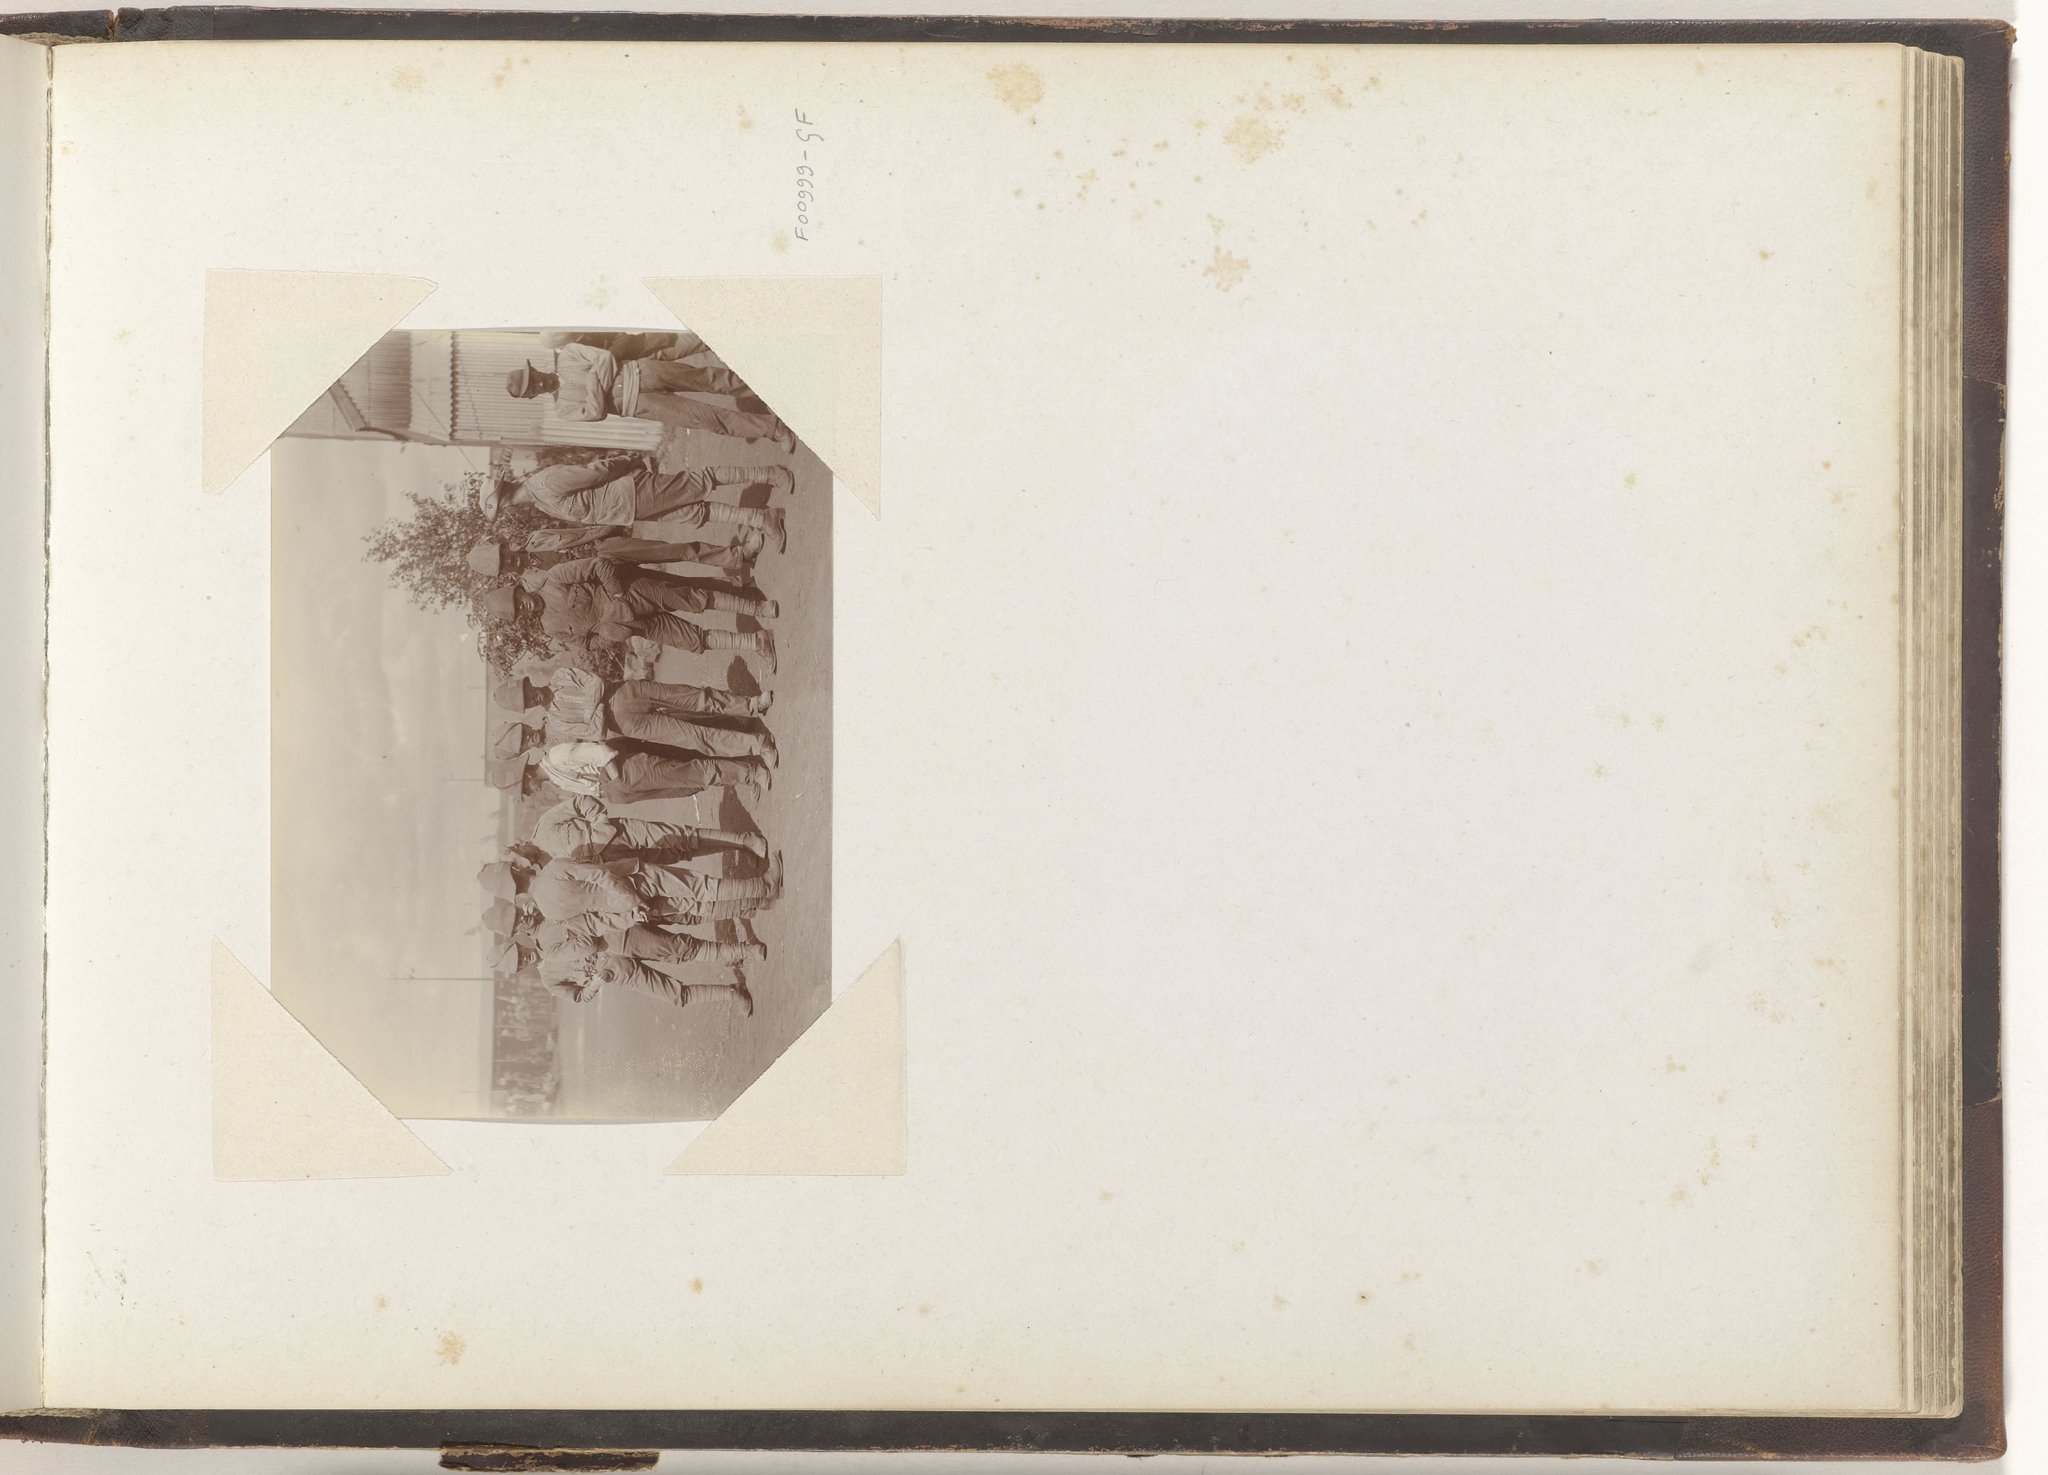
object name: photograph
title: Britse krijgsgevangenen in Zuid-Afrika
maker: Anonymous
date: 1899-1902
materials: paper, photographic support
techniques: gelatin silver print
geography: south africa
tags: prisoner of war (after the battle)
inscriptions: inscription: ‘Engelsche gevangenen.’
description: Onderdeel van Album met 191 foto's van een reis naar en door Zuid-Afrika.